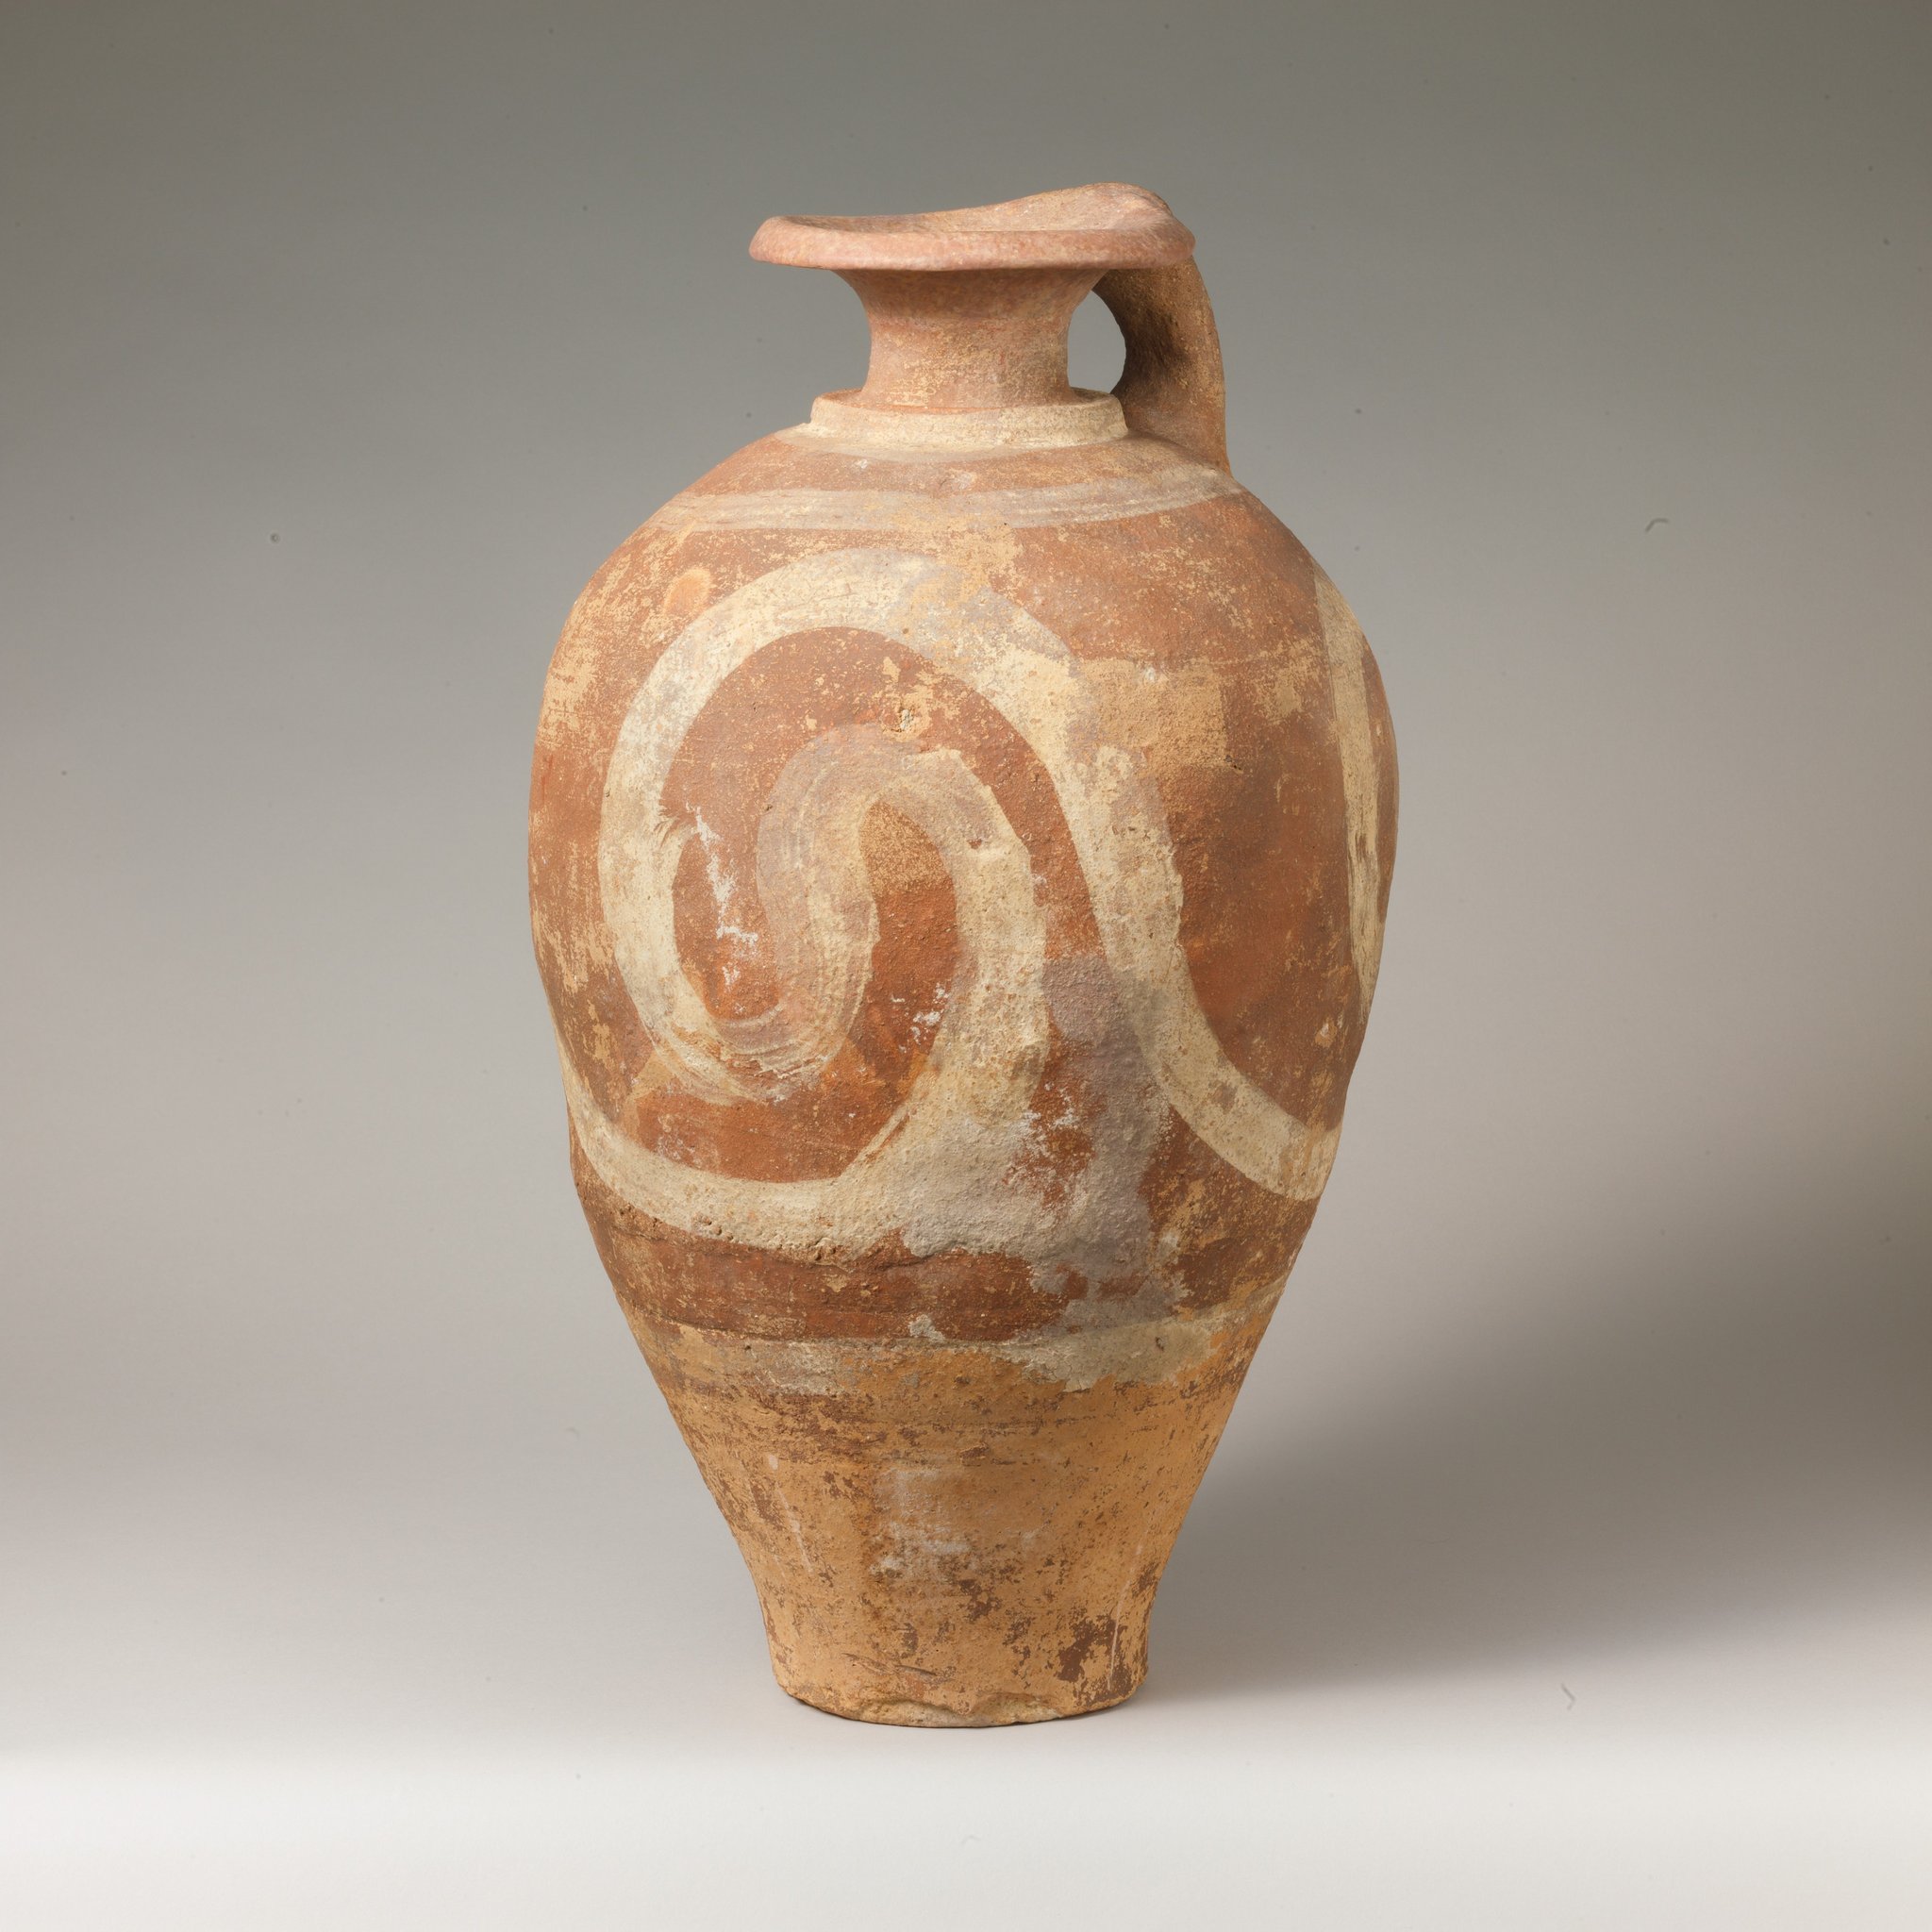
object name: jug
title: Terracotta jug with spirals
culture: minoan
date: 1700-1600 BCE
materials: terracotta